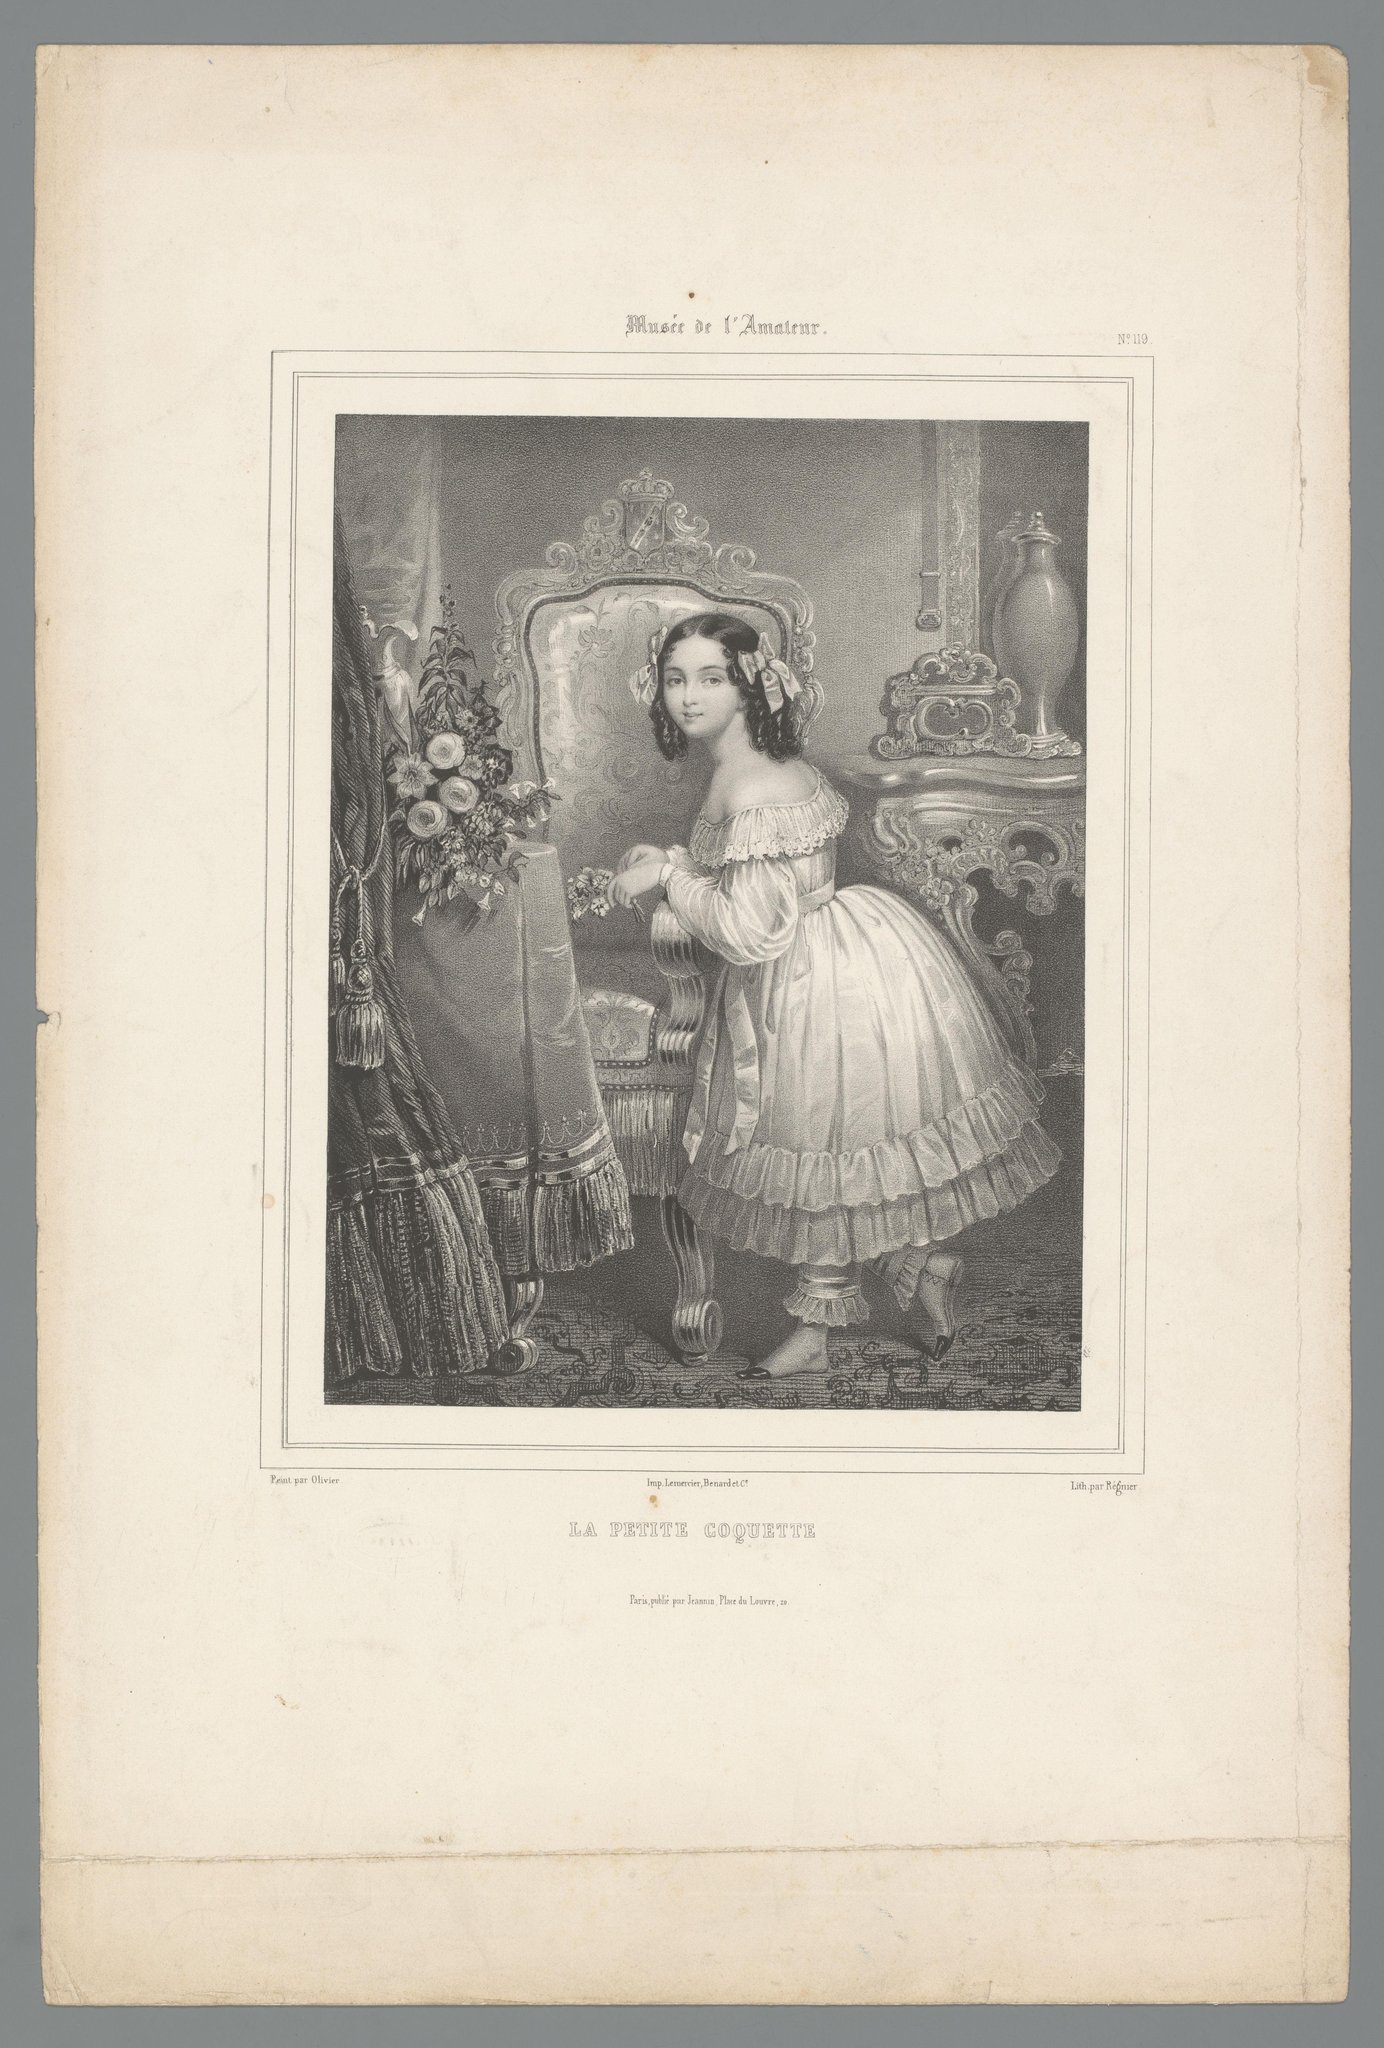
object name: print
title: Meisje met bloemen leunt op stoelleuning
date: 1841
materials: paper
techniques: lithograph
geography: paris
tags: flowers, girl (child between toddler and youth)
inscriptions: collector's mark: Lugt 2228, check stamp: Lugt 1397c